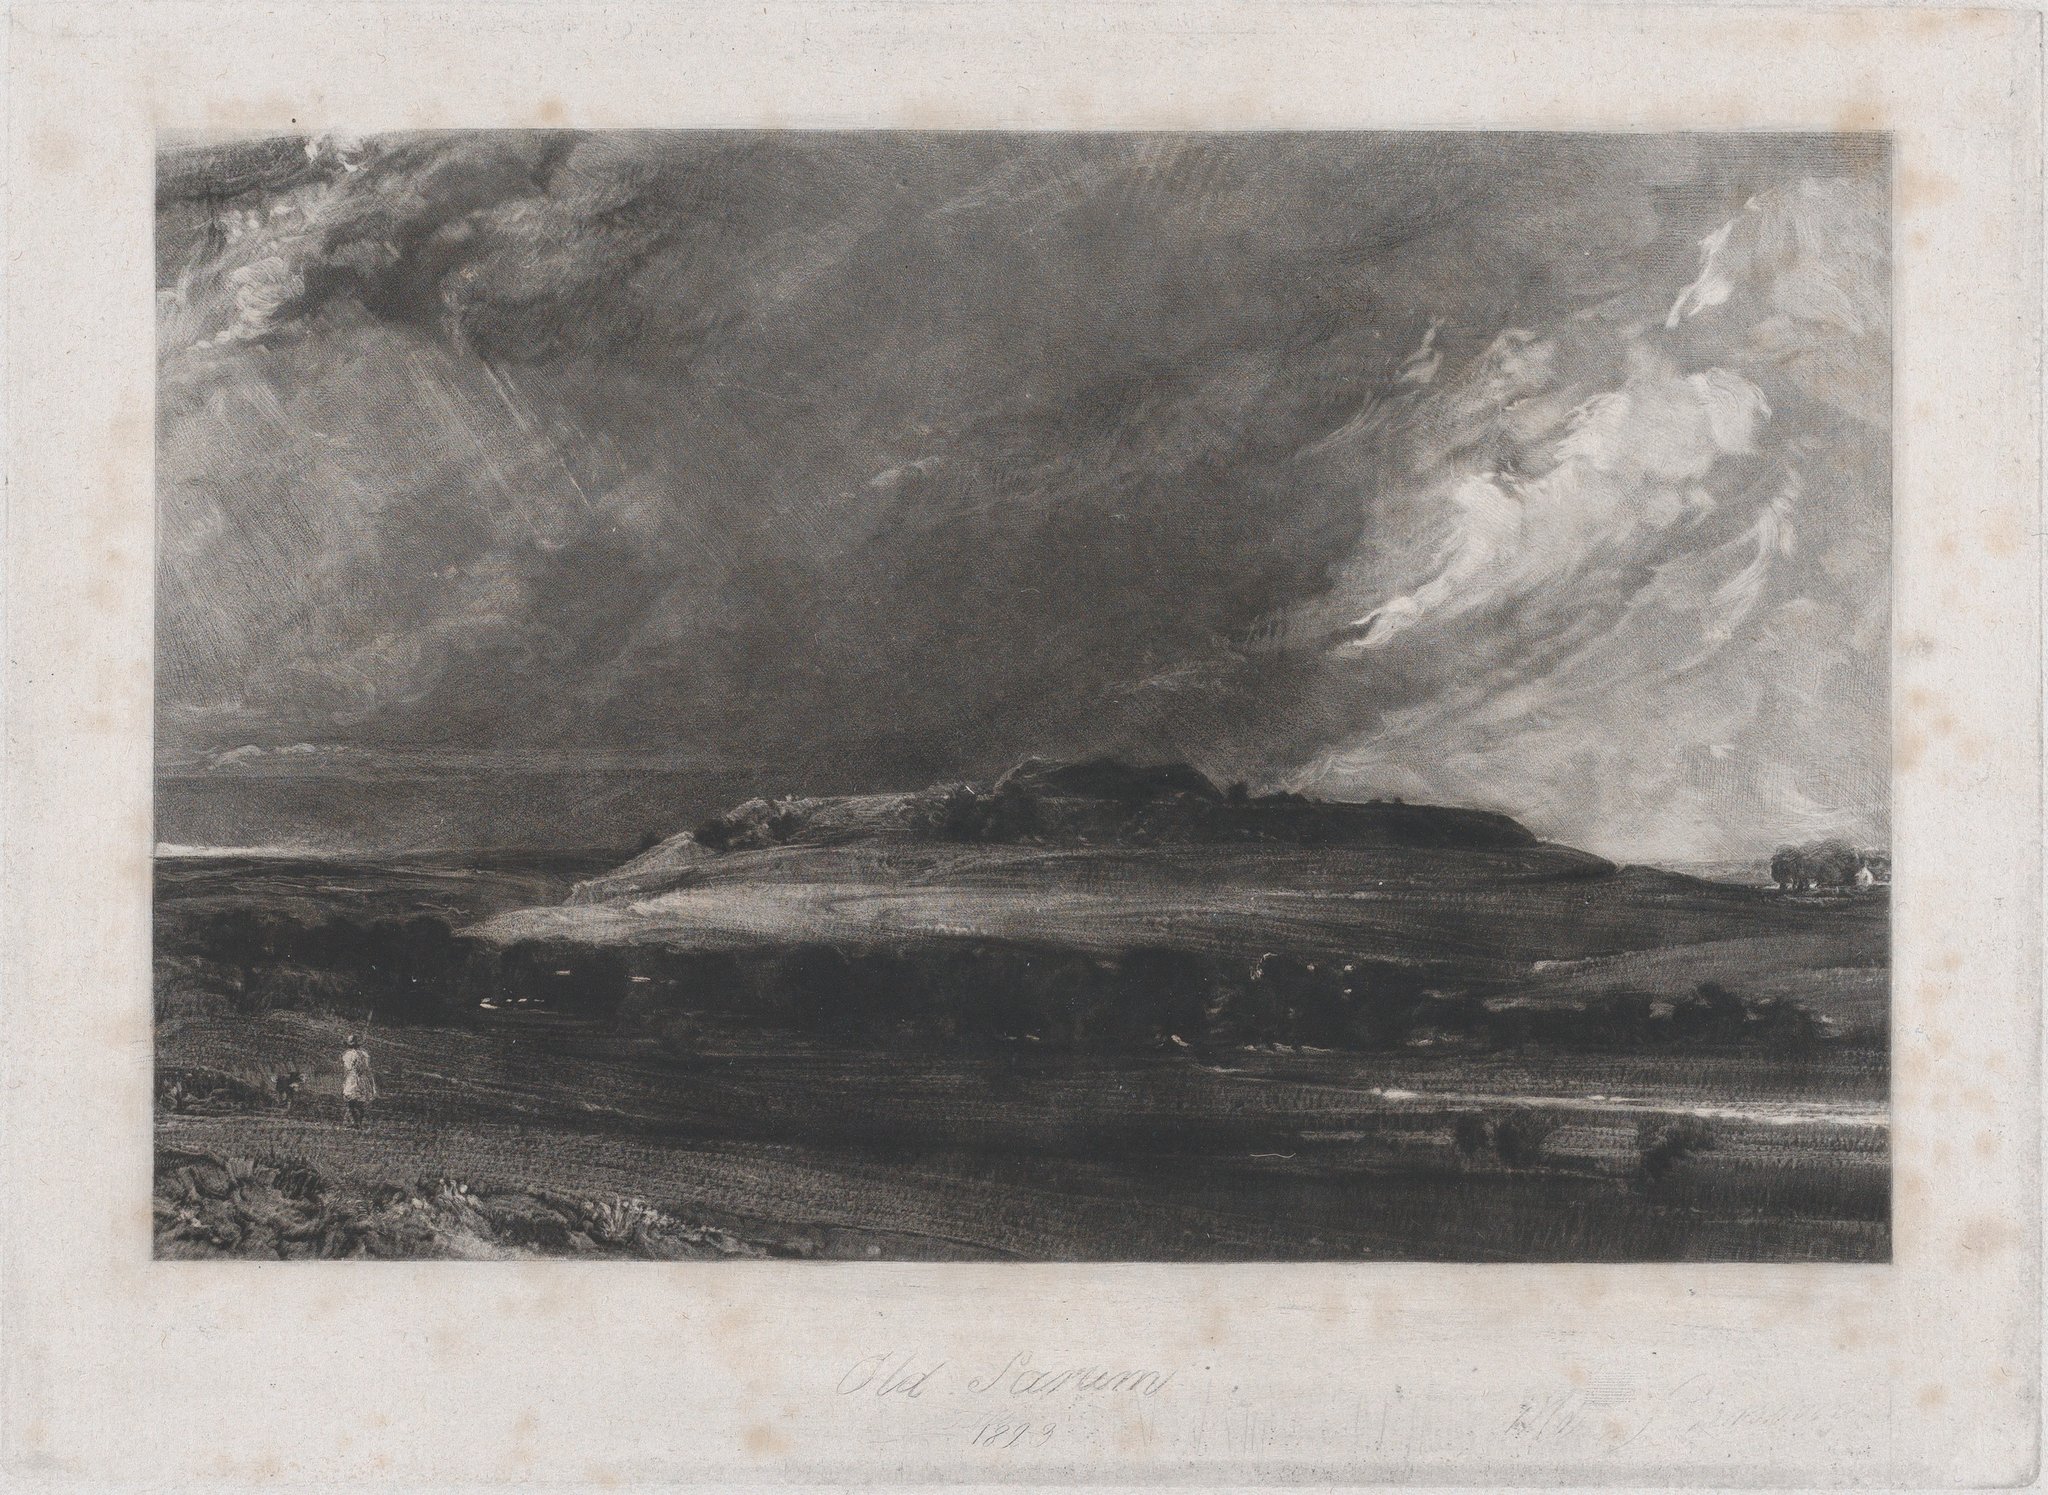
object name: print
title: Old Sarum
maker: david lucas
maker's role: artist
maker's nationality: british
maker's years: 1802-1881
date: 1830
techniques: drypoint, mezzotint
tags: landscapes,clouds